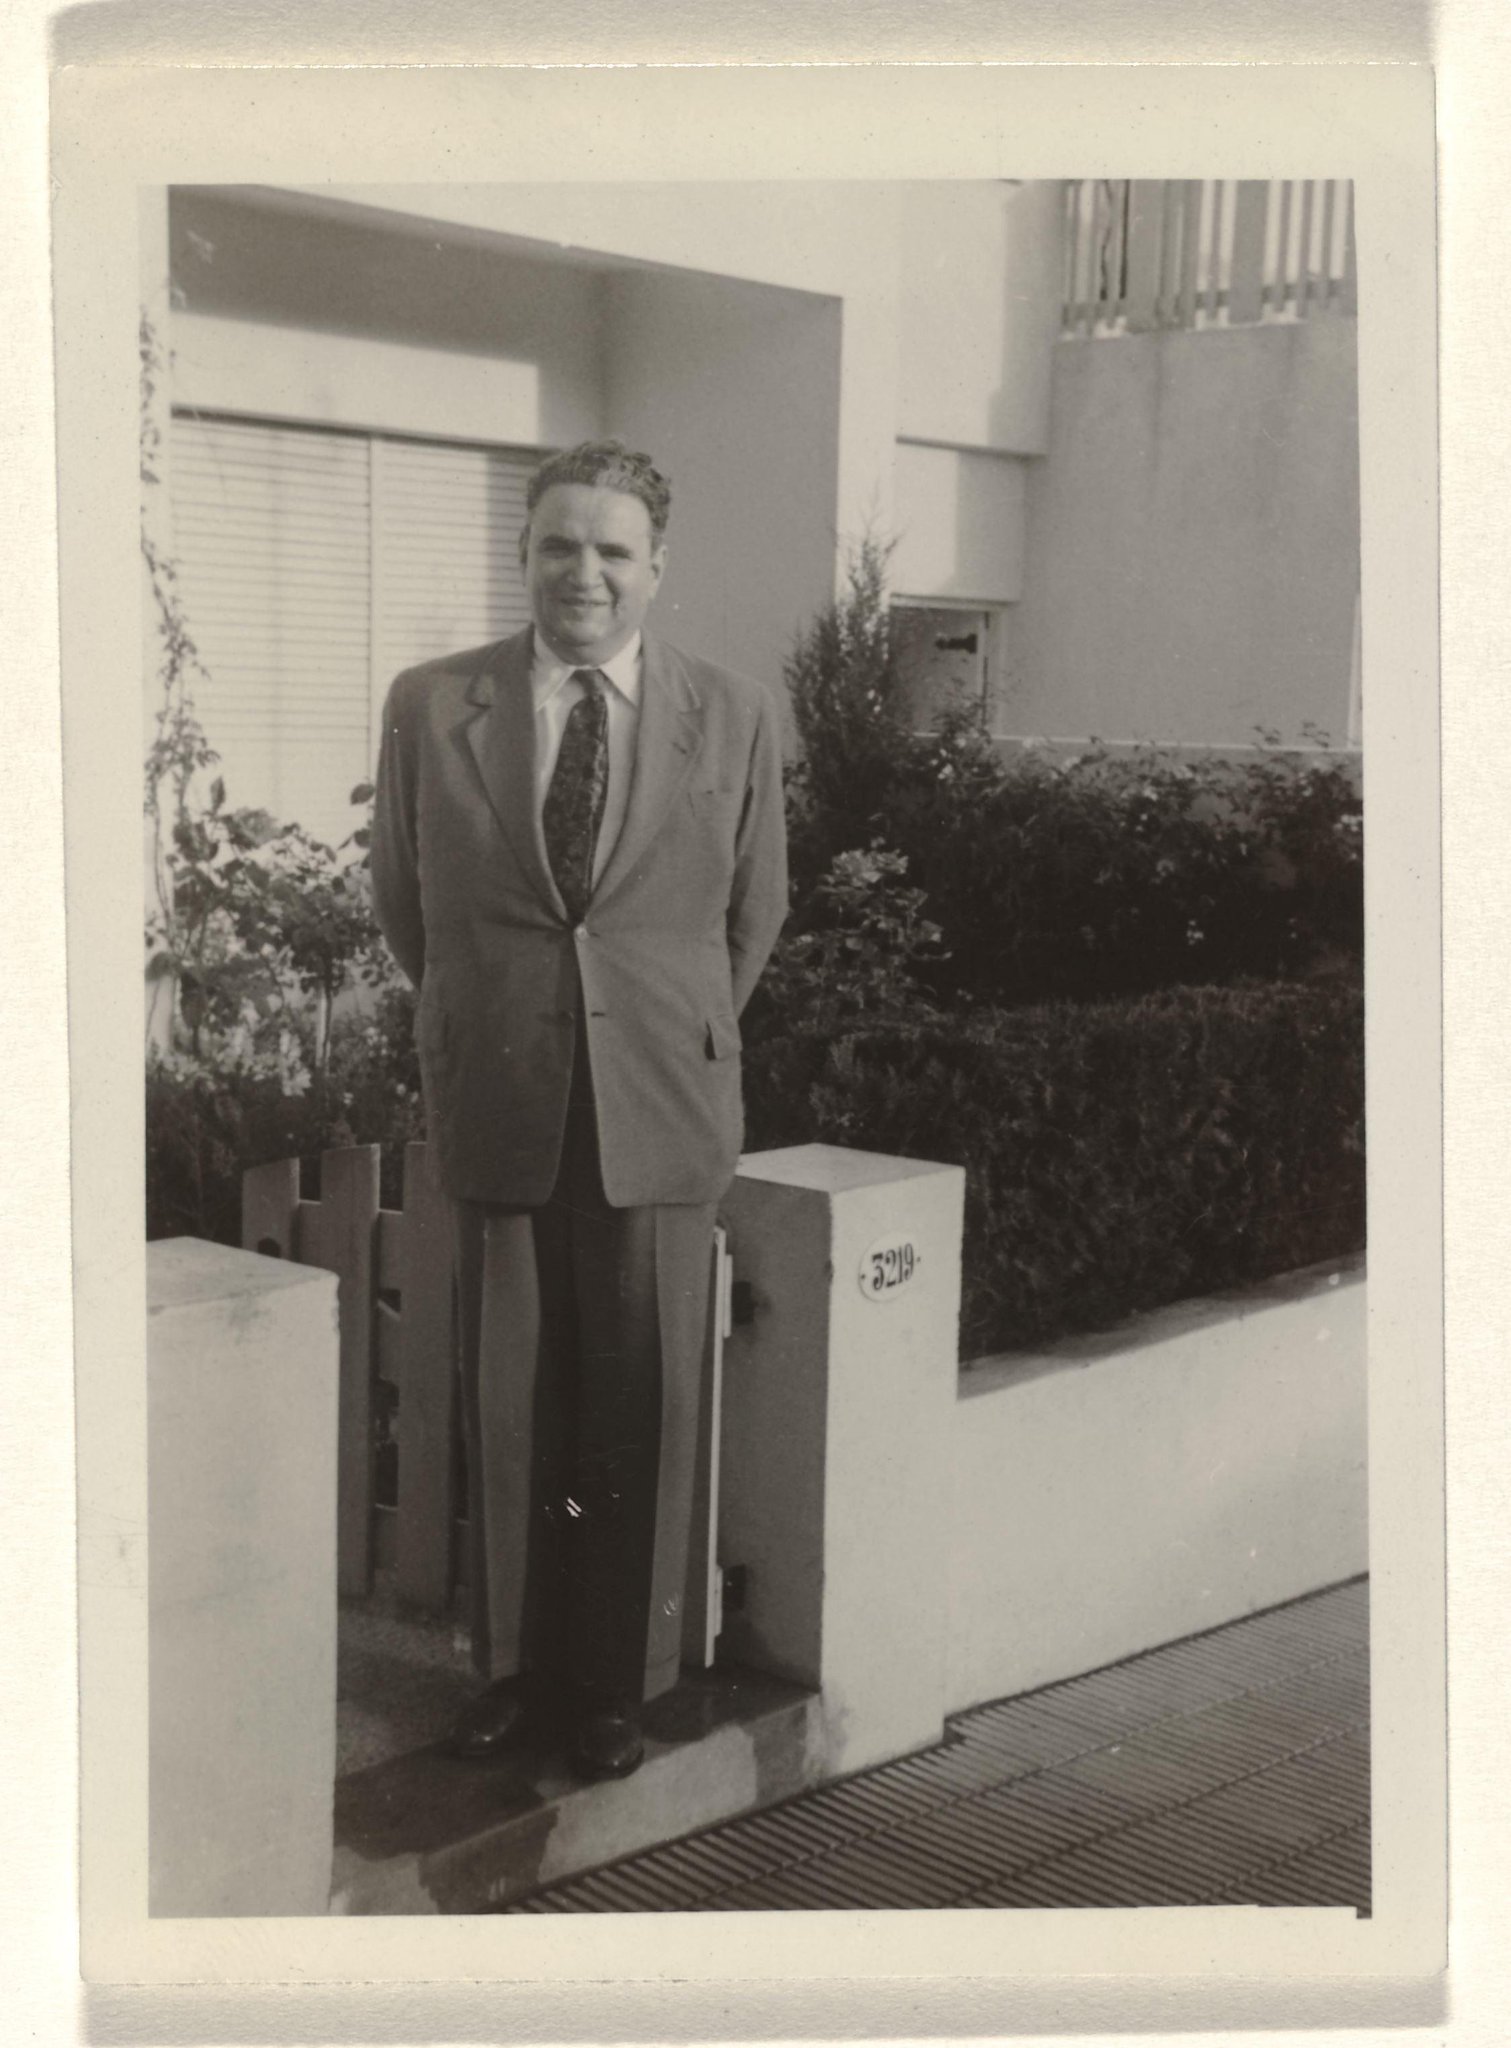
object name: photograph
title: Onbekende man in donkerlicht kostuum met donkere das en zijn armen op zijn rug gevouwen, staande voor de ingang van een gebouw met nummer 3219 en een begroeide tuin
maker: Anonymous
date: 1912-1948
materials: photographic support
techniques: gelatin silver print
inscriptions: inscription: ‘Von dem Hause von ... Beate Dez. 1948. 44’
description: Onbekende man in donkerlicht kostuum met donkere das en zijn armen op zijn rug gevouwen, staande voor de ingang van een gebouw met nummer 3219 en een begroeide tuin.